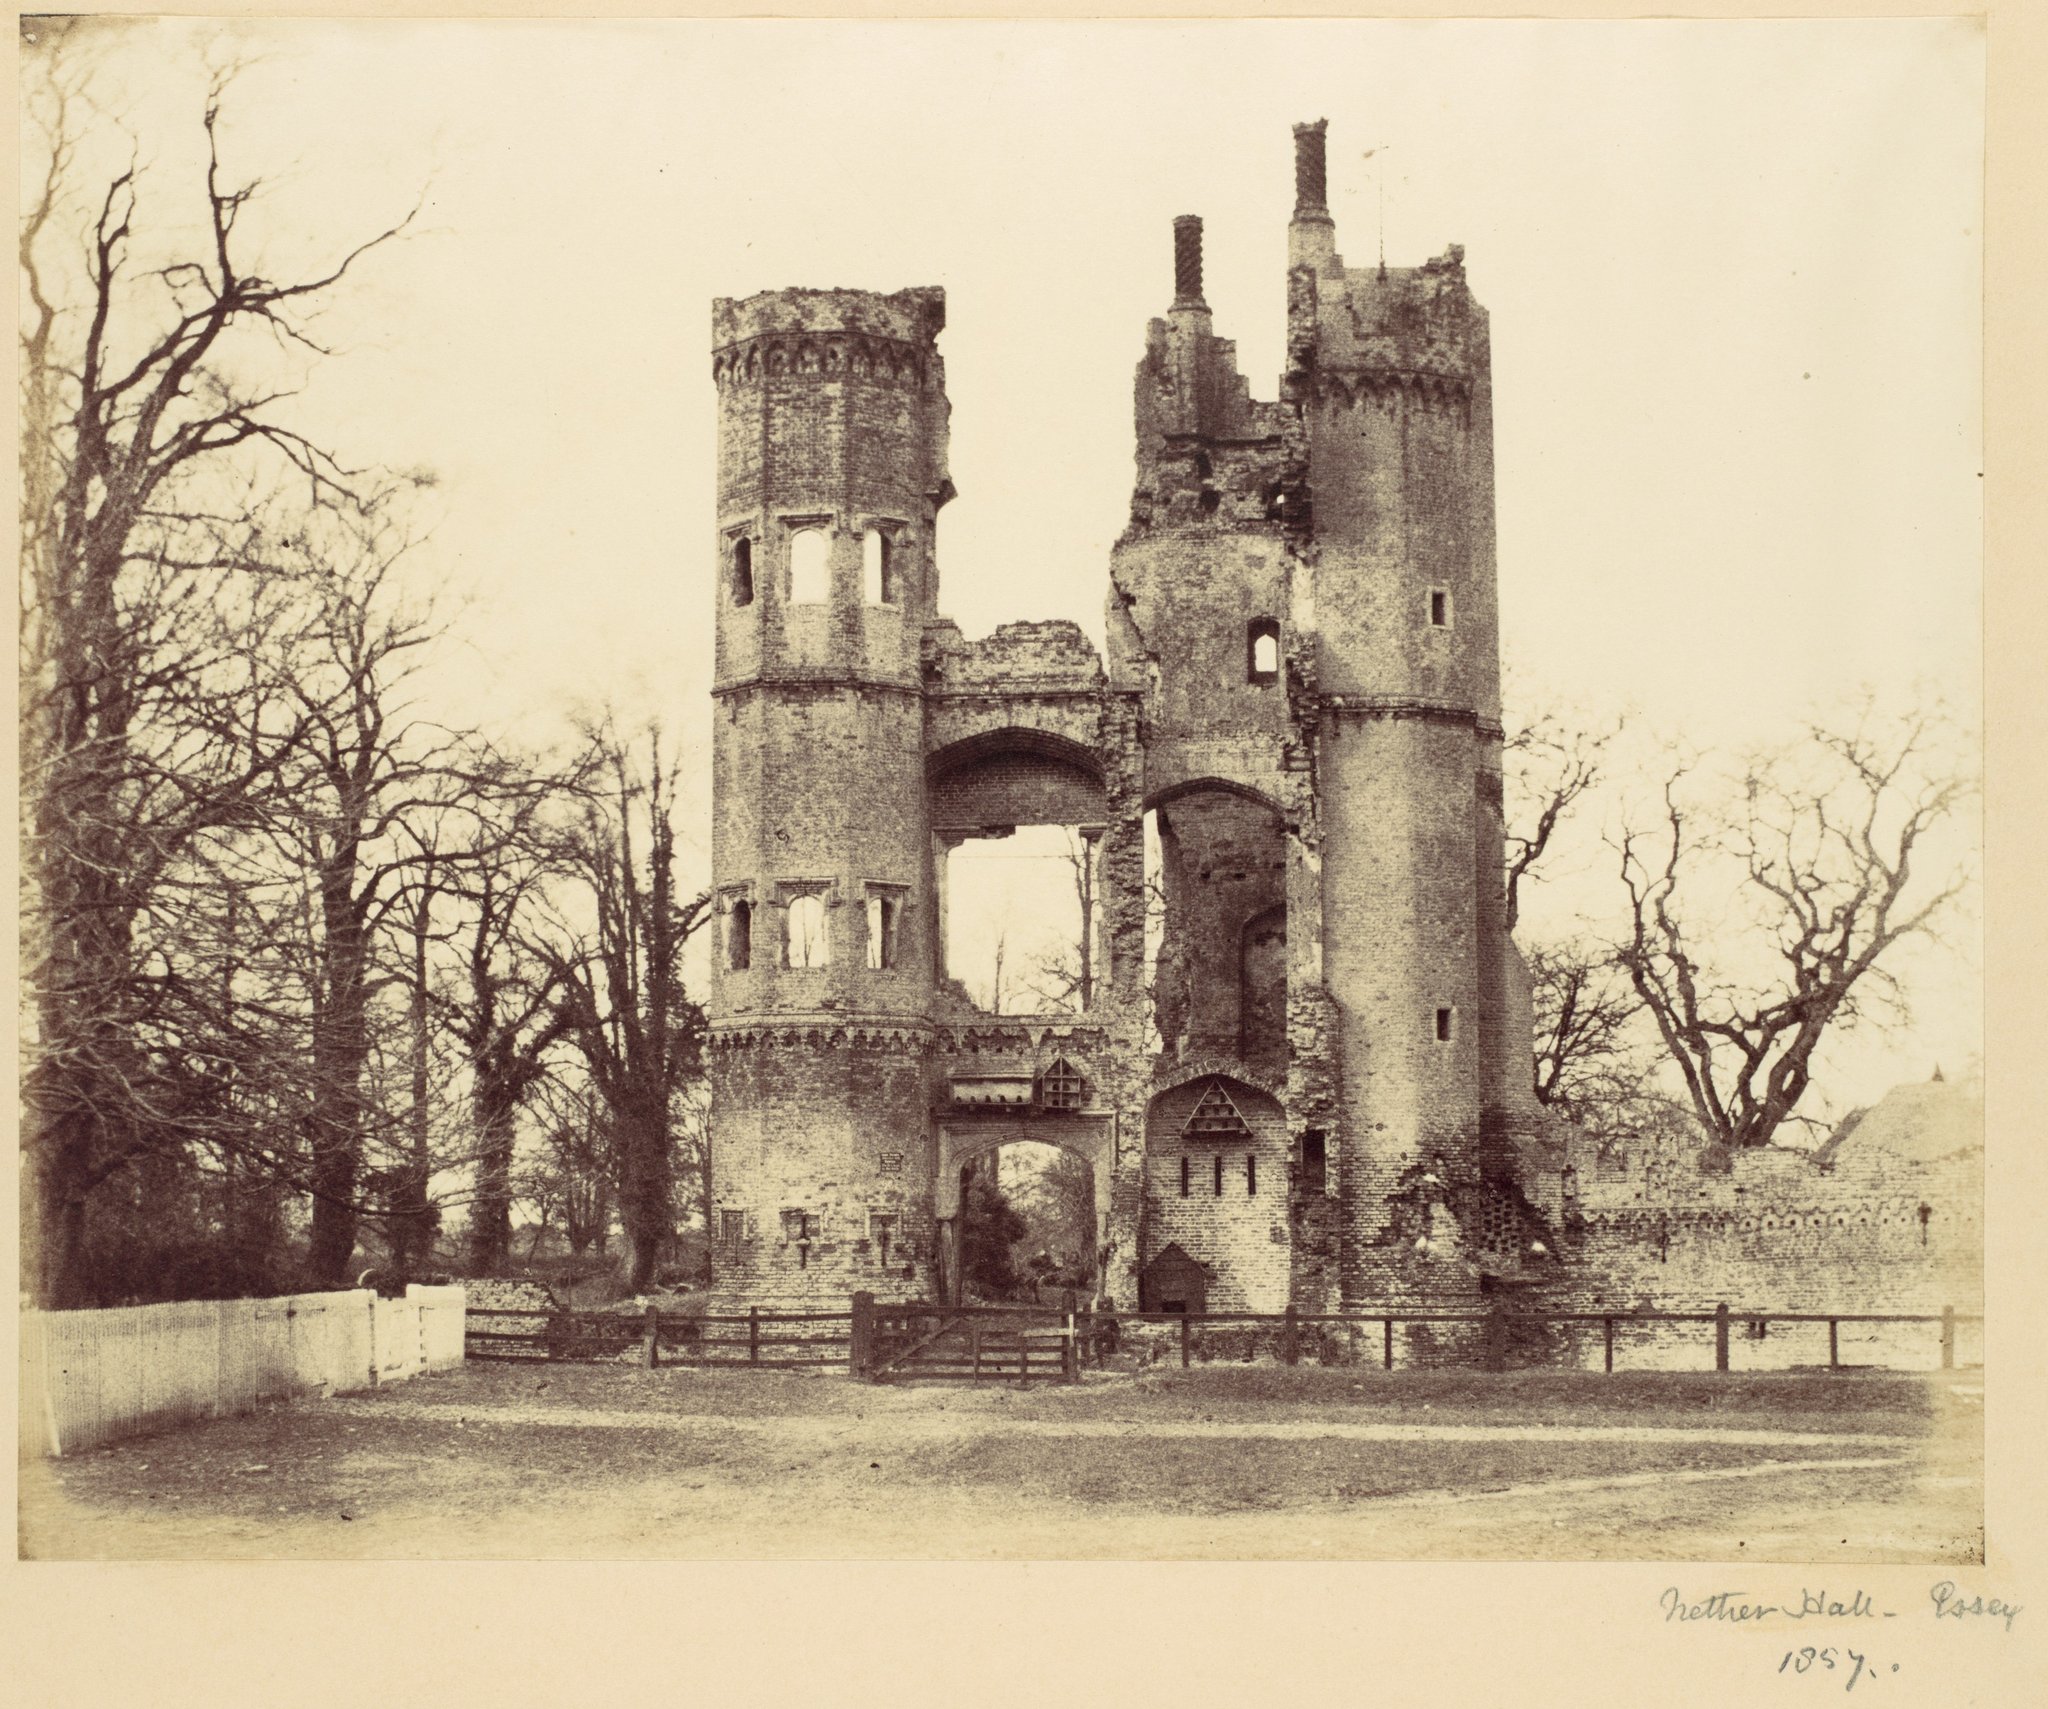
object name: photograph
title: Nether Hall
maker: alfred capel cure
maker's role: artist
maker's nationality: british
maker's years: 1826-1896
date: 1857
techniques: albumen silver print, paper negative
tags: architecture,ruins